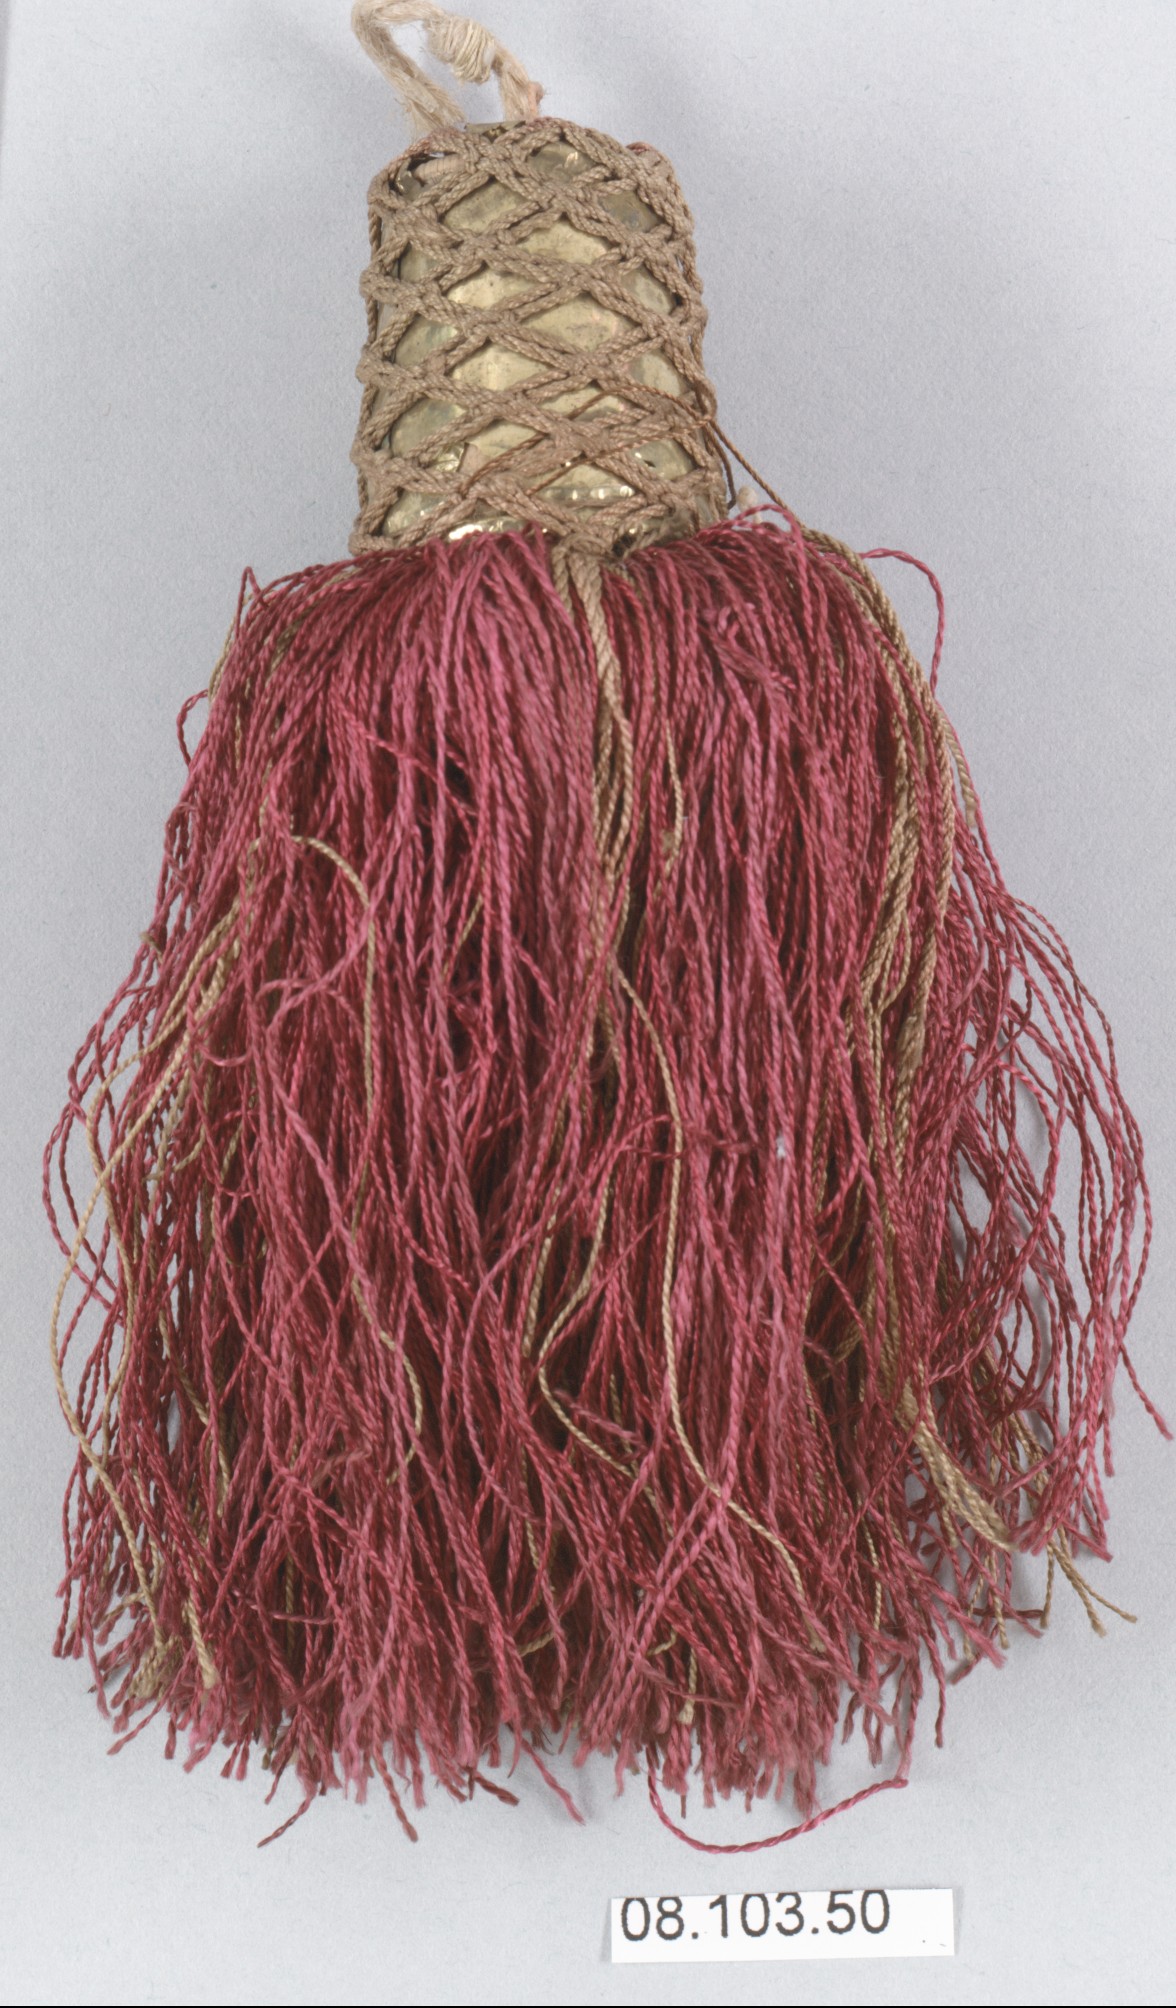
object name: tassel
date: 1701-1800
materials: metal thread, silk